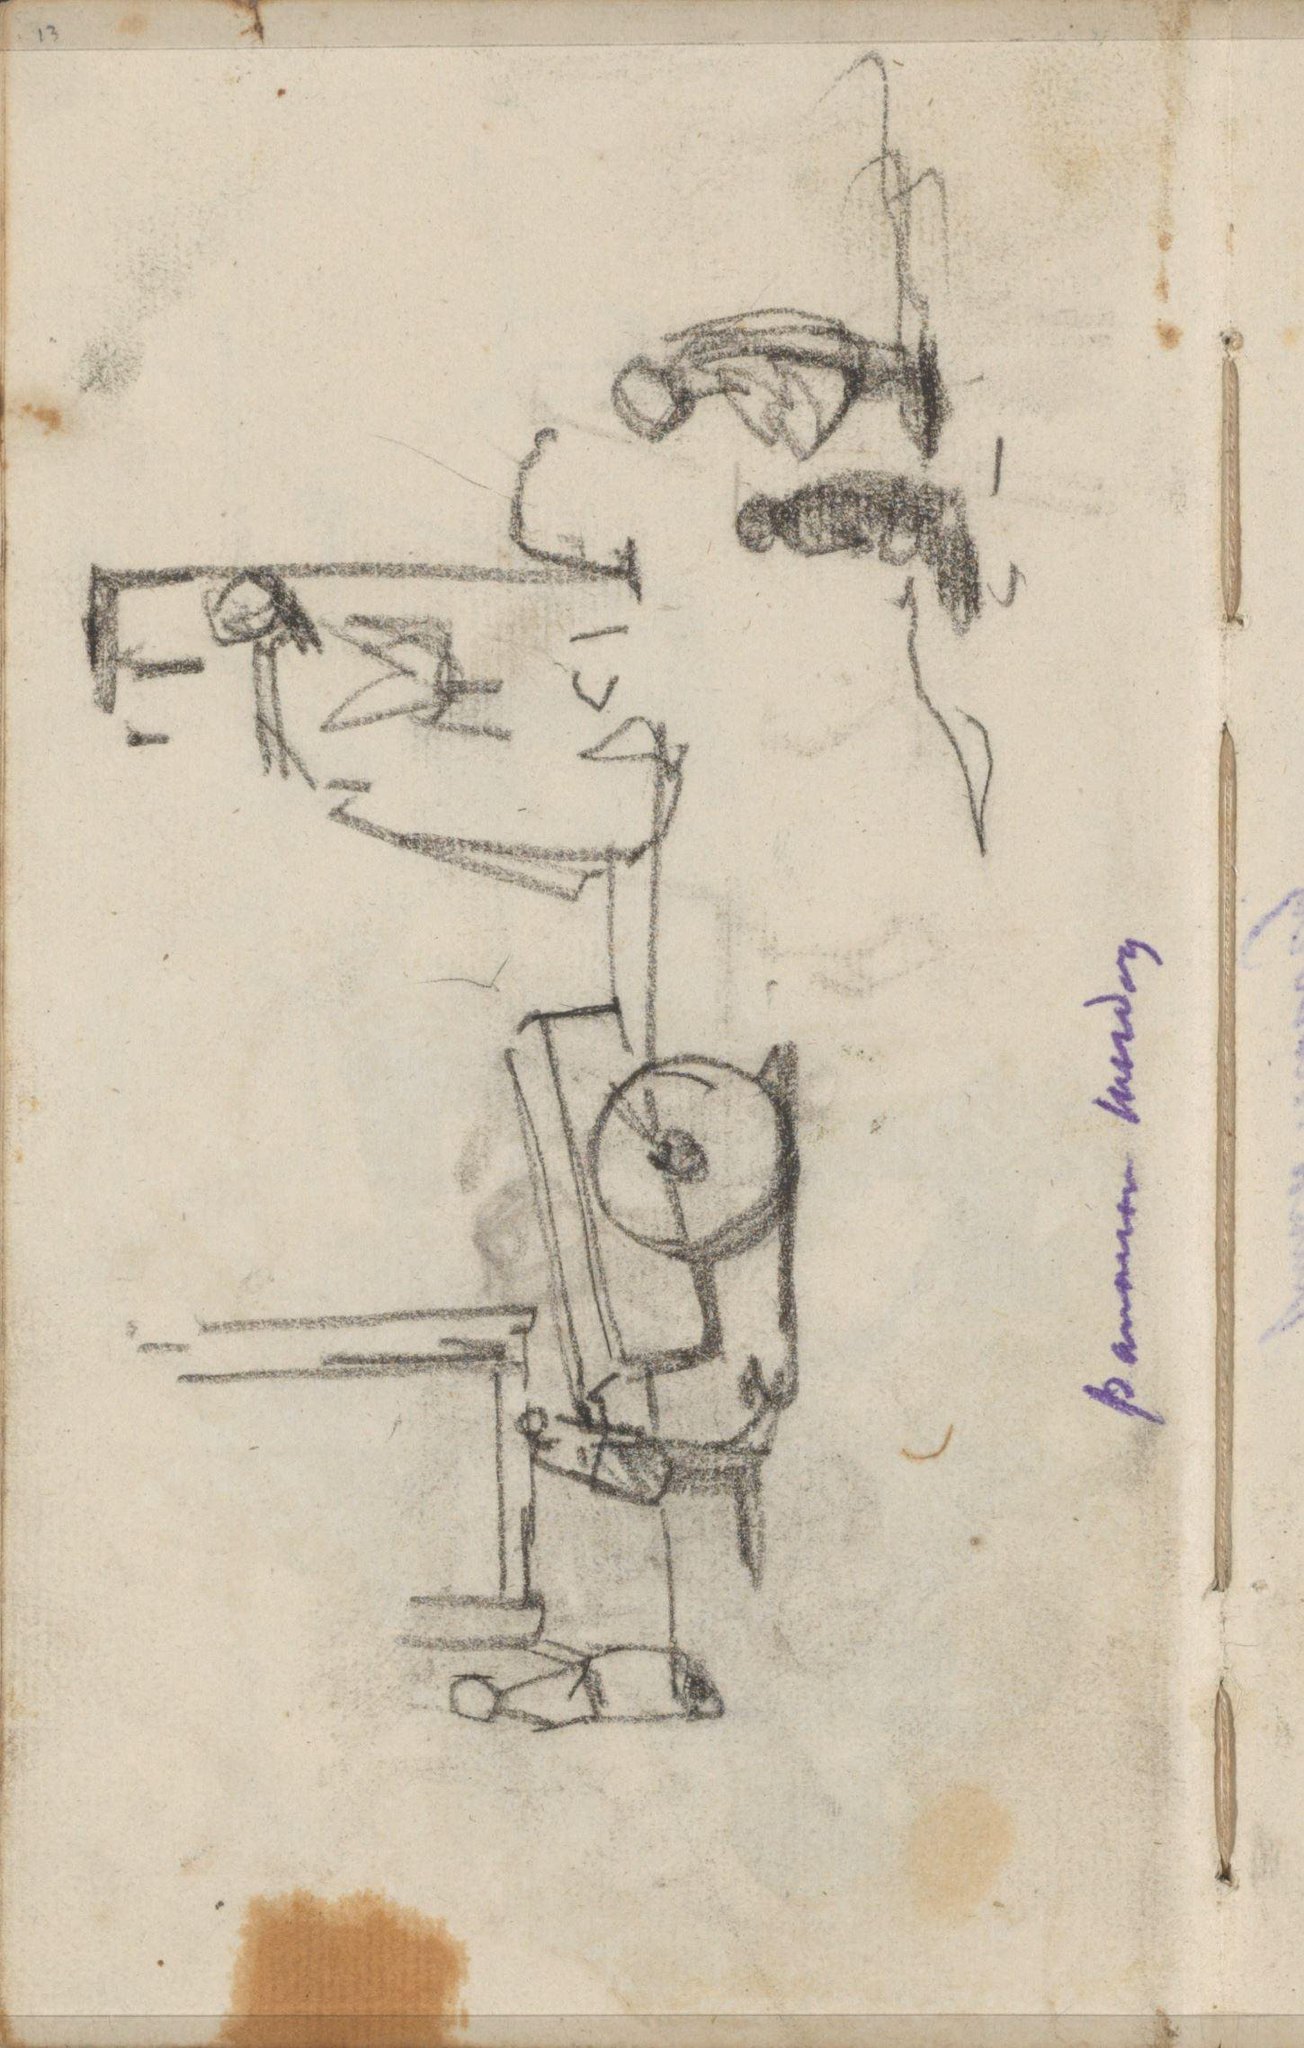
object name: sketchbook leaf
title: Figuren en een kar voor een huis in Scheveningen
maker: george hendrik breitner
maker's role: draughtsman, painter, print maker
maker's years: 1857-1923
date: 1880-1882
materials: chalk, paper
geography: scheveningen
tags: hand-cart, urban housing, adult woman, child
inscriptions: annotation: ‘Panorama Mesdag’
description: Pagina 13 uit een schetsboek met 31 bladen.